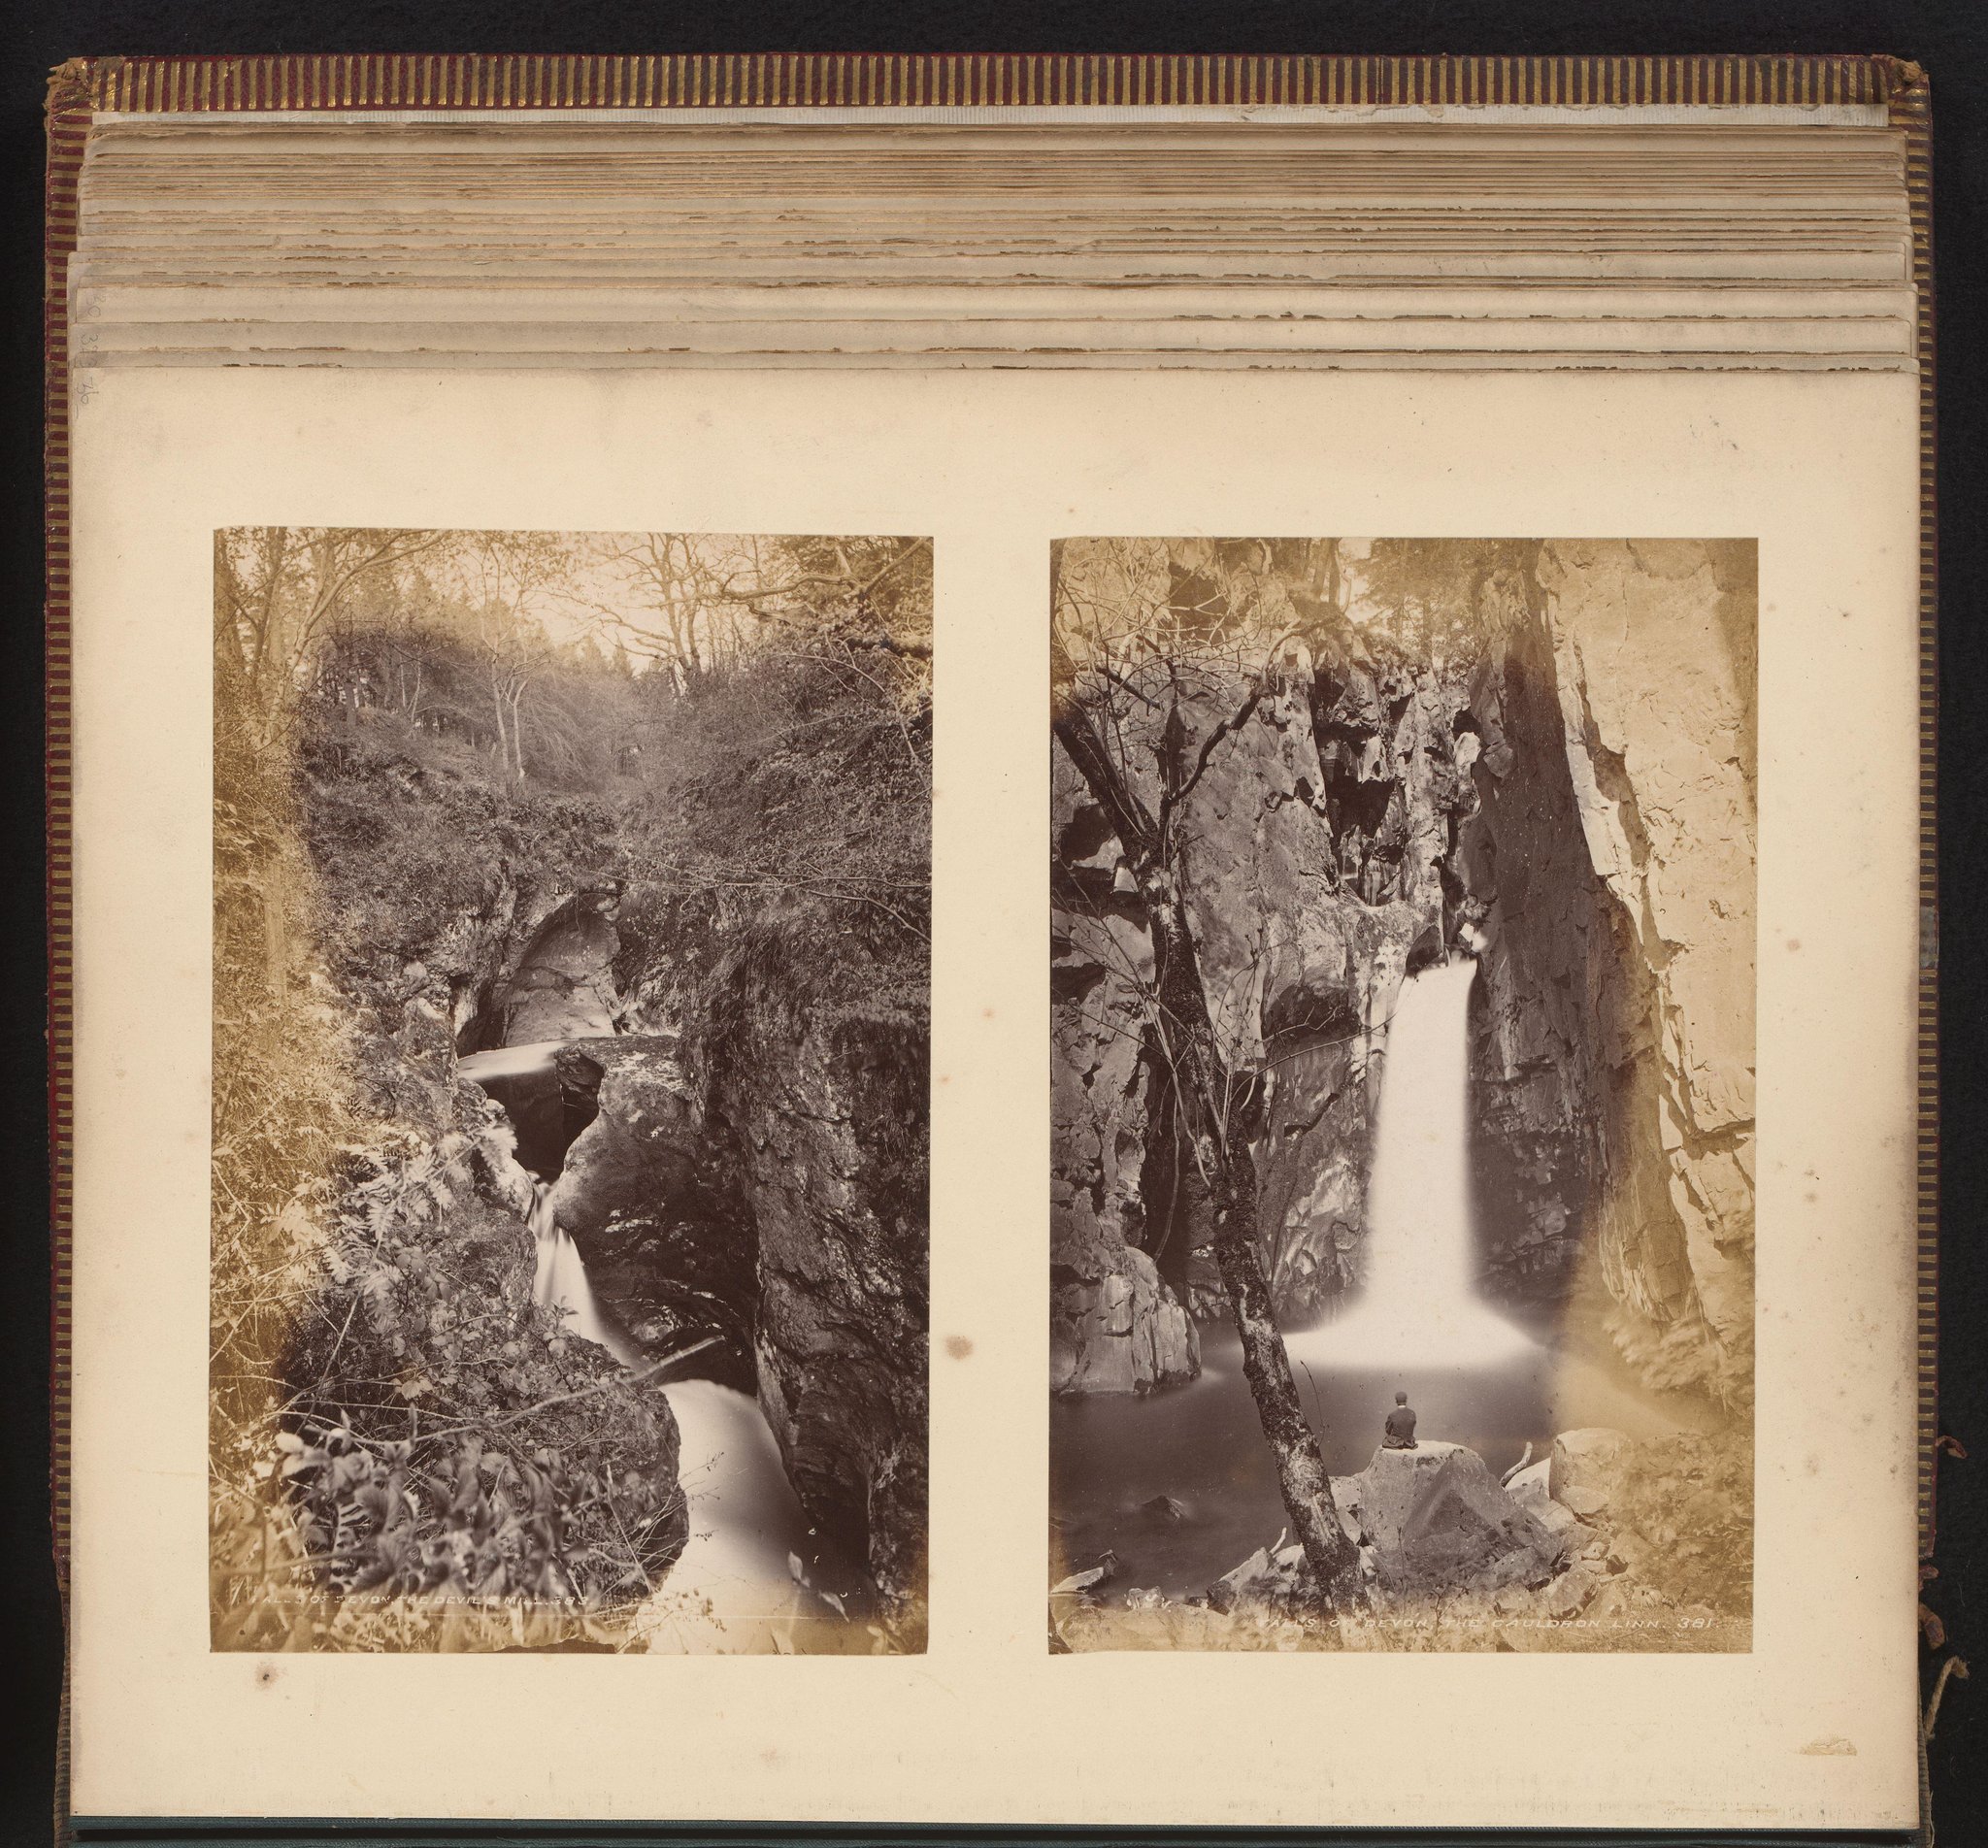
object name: album leaf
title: Falls of Devon, the Cauldron Linn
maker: Anonymous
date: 1875-1885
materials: photographic support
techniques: albumen print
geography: perth and kinross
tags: waterfall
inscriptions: number: ‘381, J.V.’, number: ‘383, J.V.’